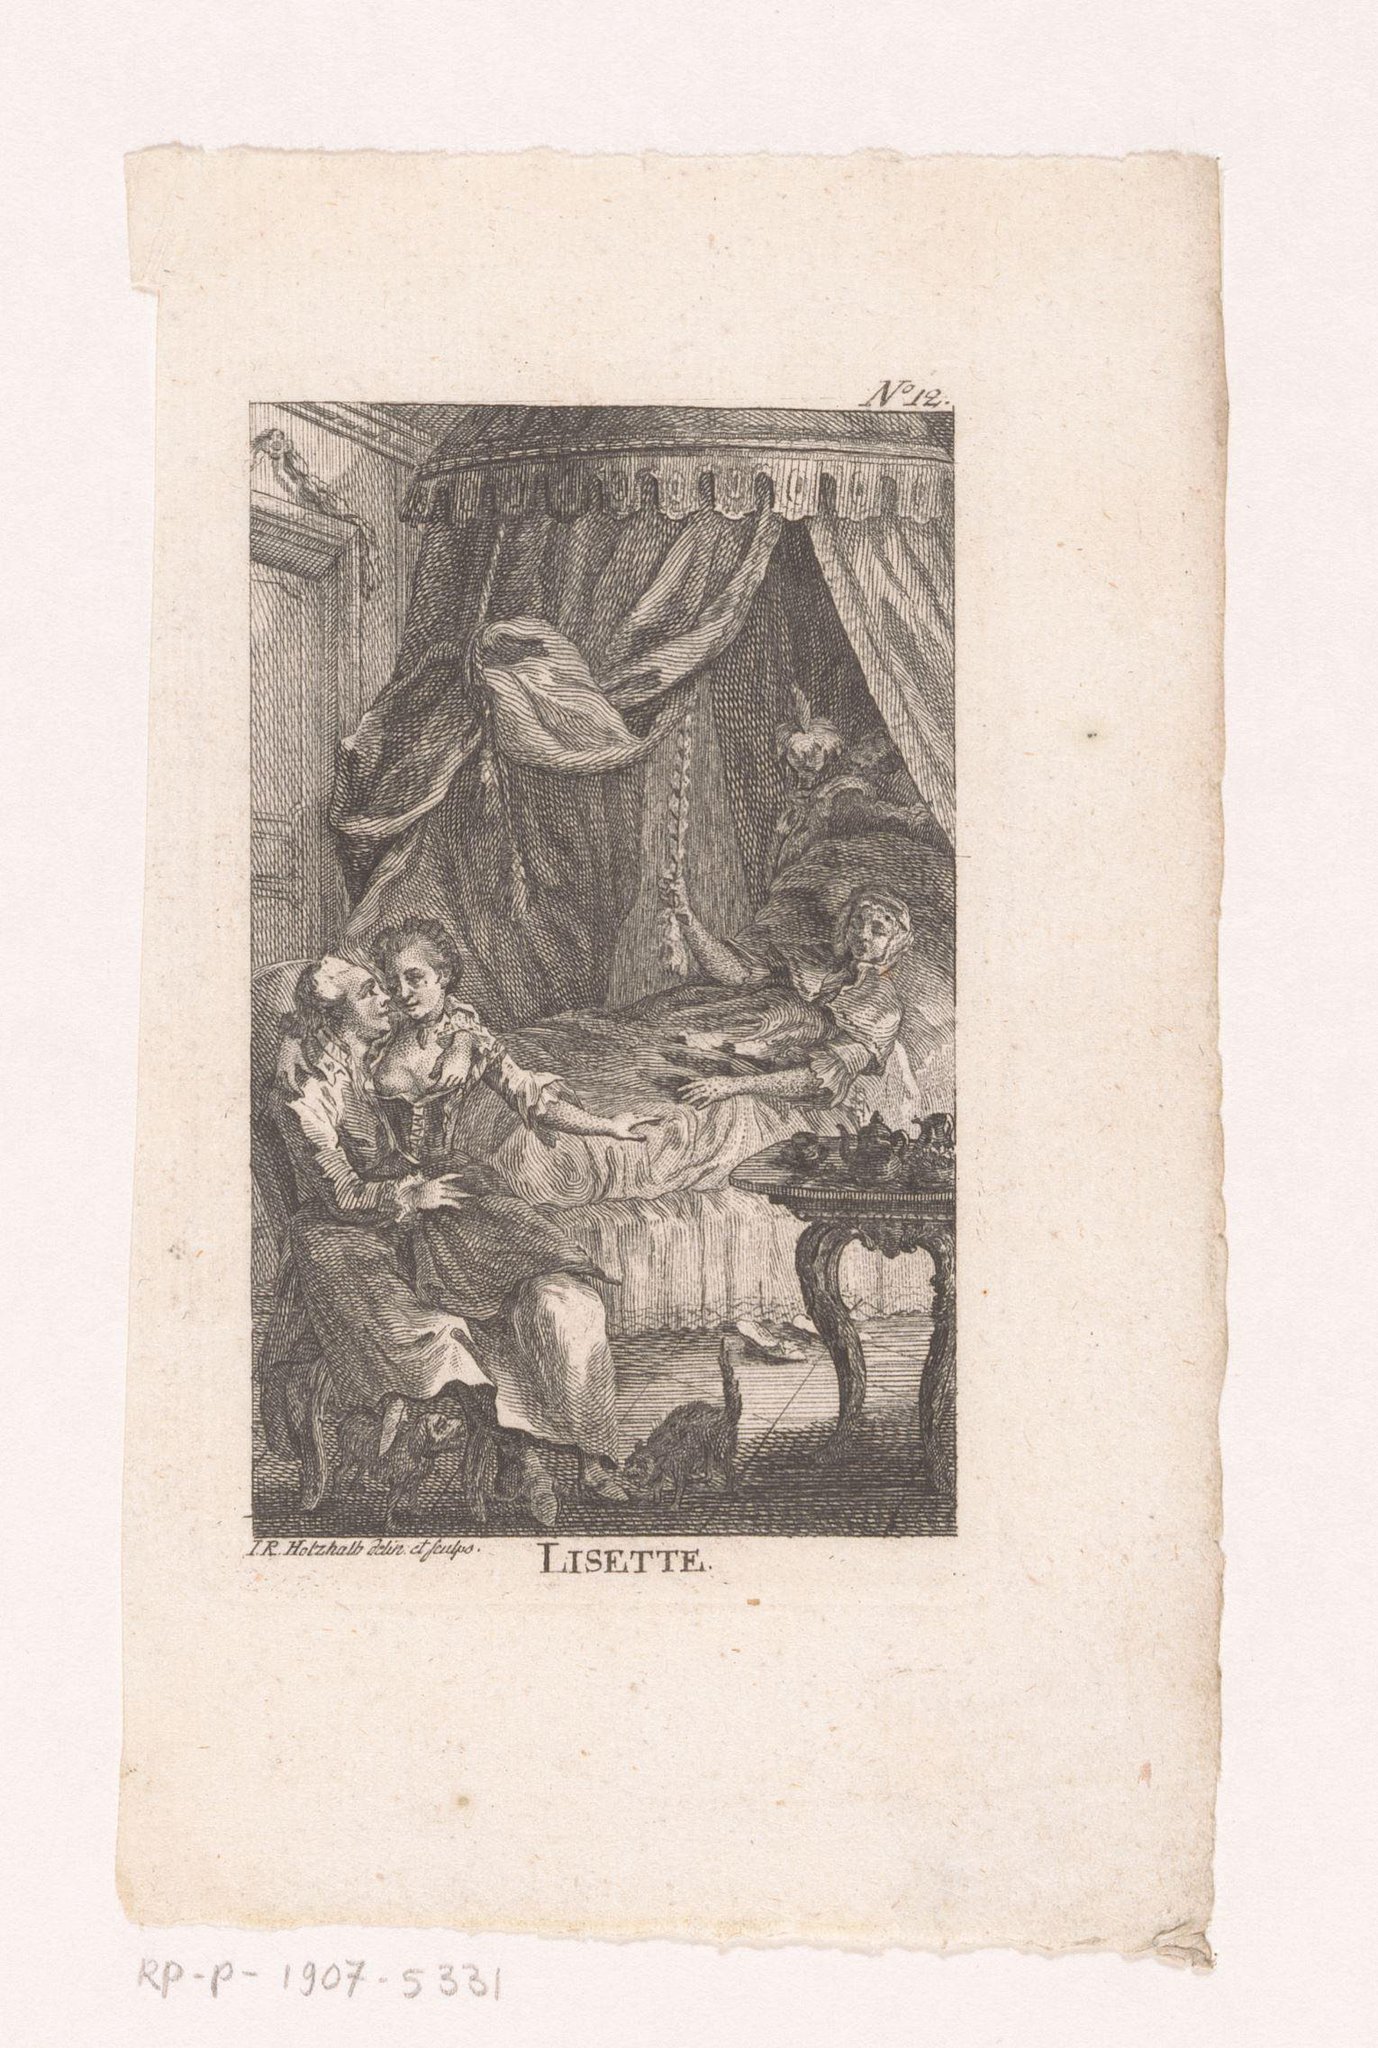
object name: print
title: Lisette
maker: johann rudolph holzhalb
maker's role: print maker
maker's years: 1723-1806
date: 1746-1806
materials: paper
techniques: etching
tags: partner deceived, partner deceived - dd - deceived wife, patient, sick person, maid ~ house personnel, couple of lovers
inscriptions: collector's mark: Lugt 2228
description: De prent is nummer twaalf uit een serie. Deze prent is waarschijnlijk gebaseerd op de illustratie en/of het verhaal uit: Gellert, Christian Fürchtegott. Fabelen en vertelsels. 3 dln. Amsterdam: Pieter Meyer, 1772-1774.